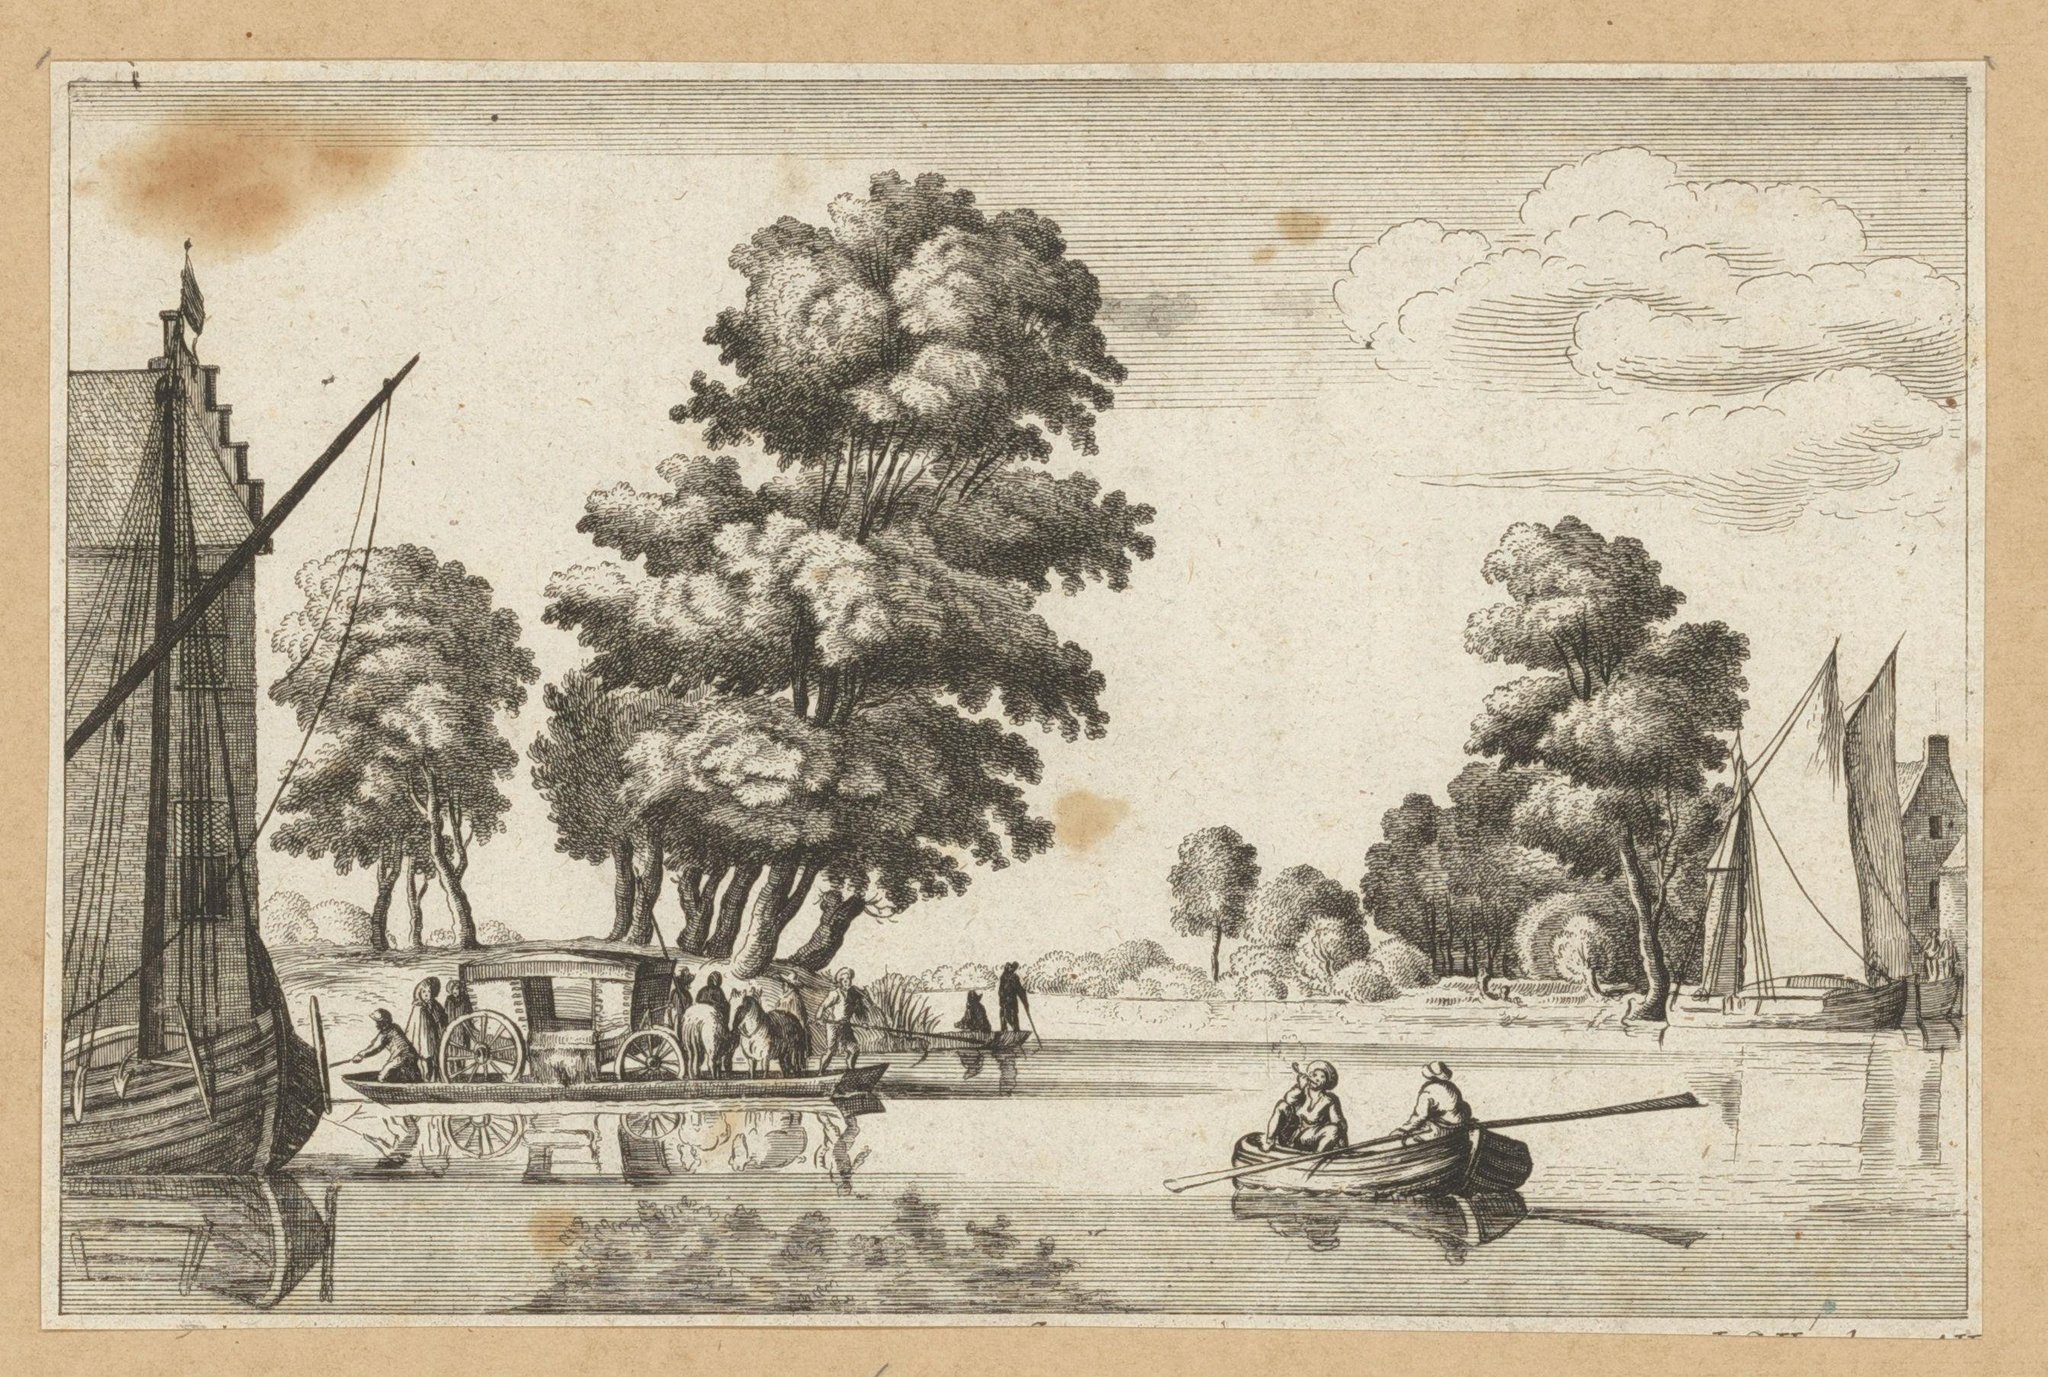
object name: print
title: Gezicht op de Maas met veerpont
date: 1651-1699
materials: paper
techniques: etching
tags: ferry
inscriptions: stamp, stamp, collector's mark: Lugt 1641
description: Gezicht op de Maas met veerpont. De veerpont zet een koets en twee paarden over. Onderwerpsrubrieken binnen de Atlas Zeden en Gewoonten: Handel, nijverheid en verkeer, Vervoermiddelen te land en te water, Vervoermiddelen te water.